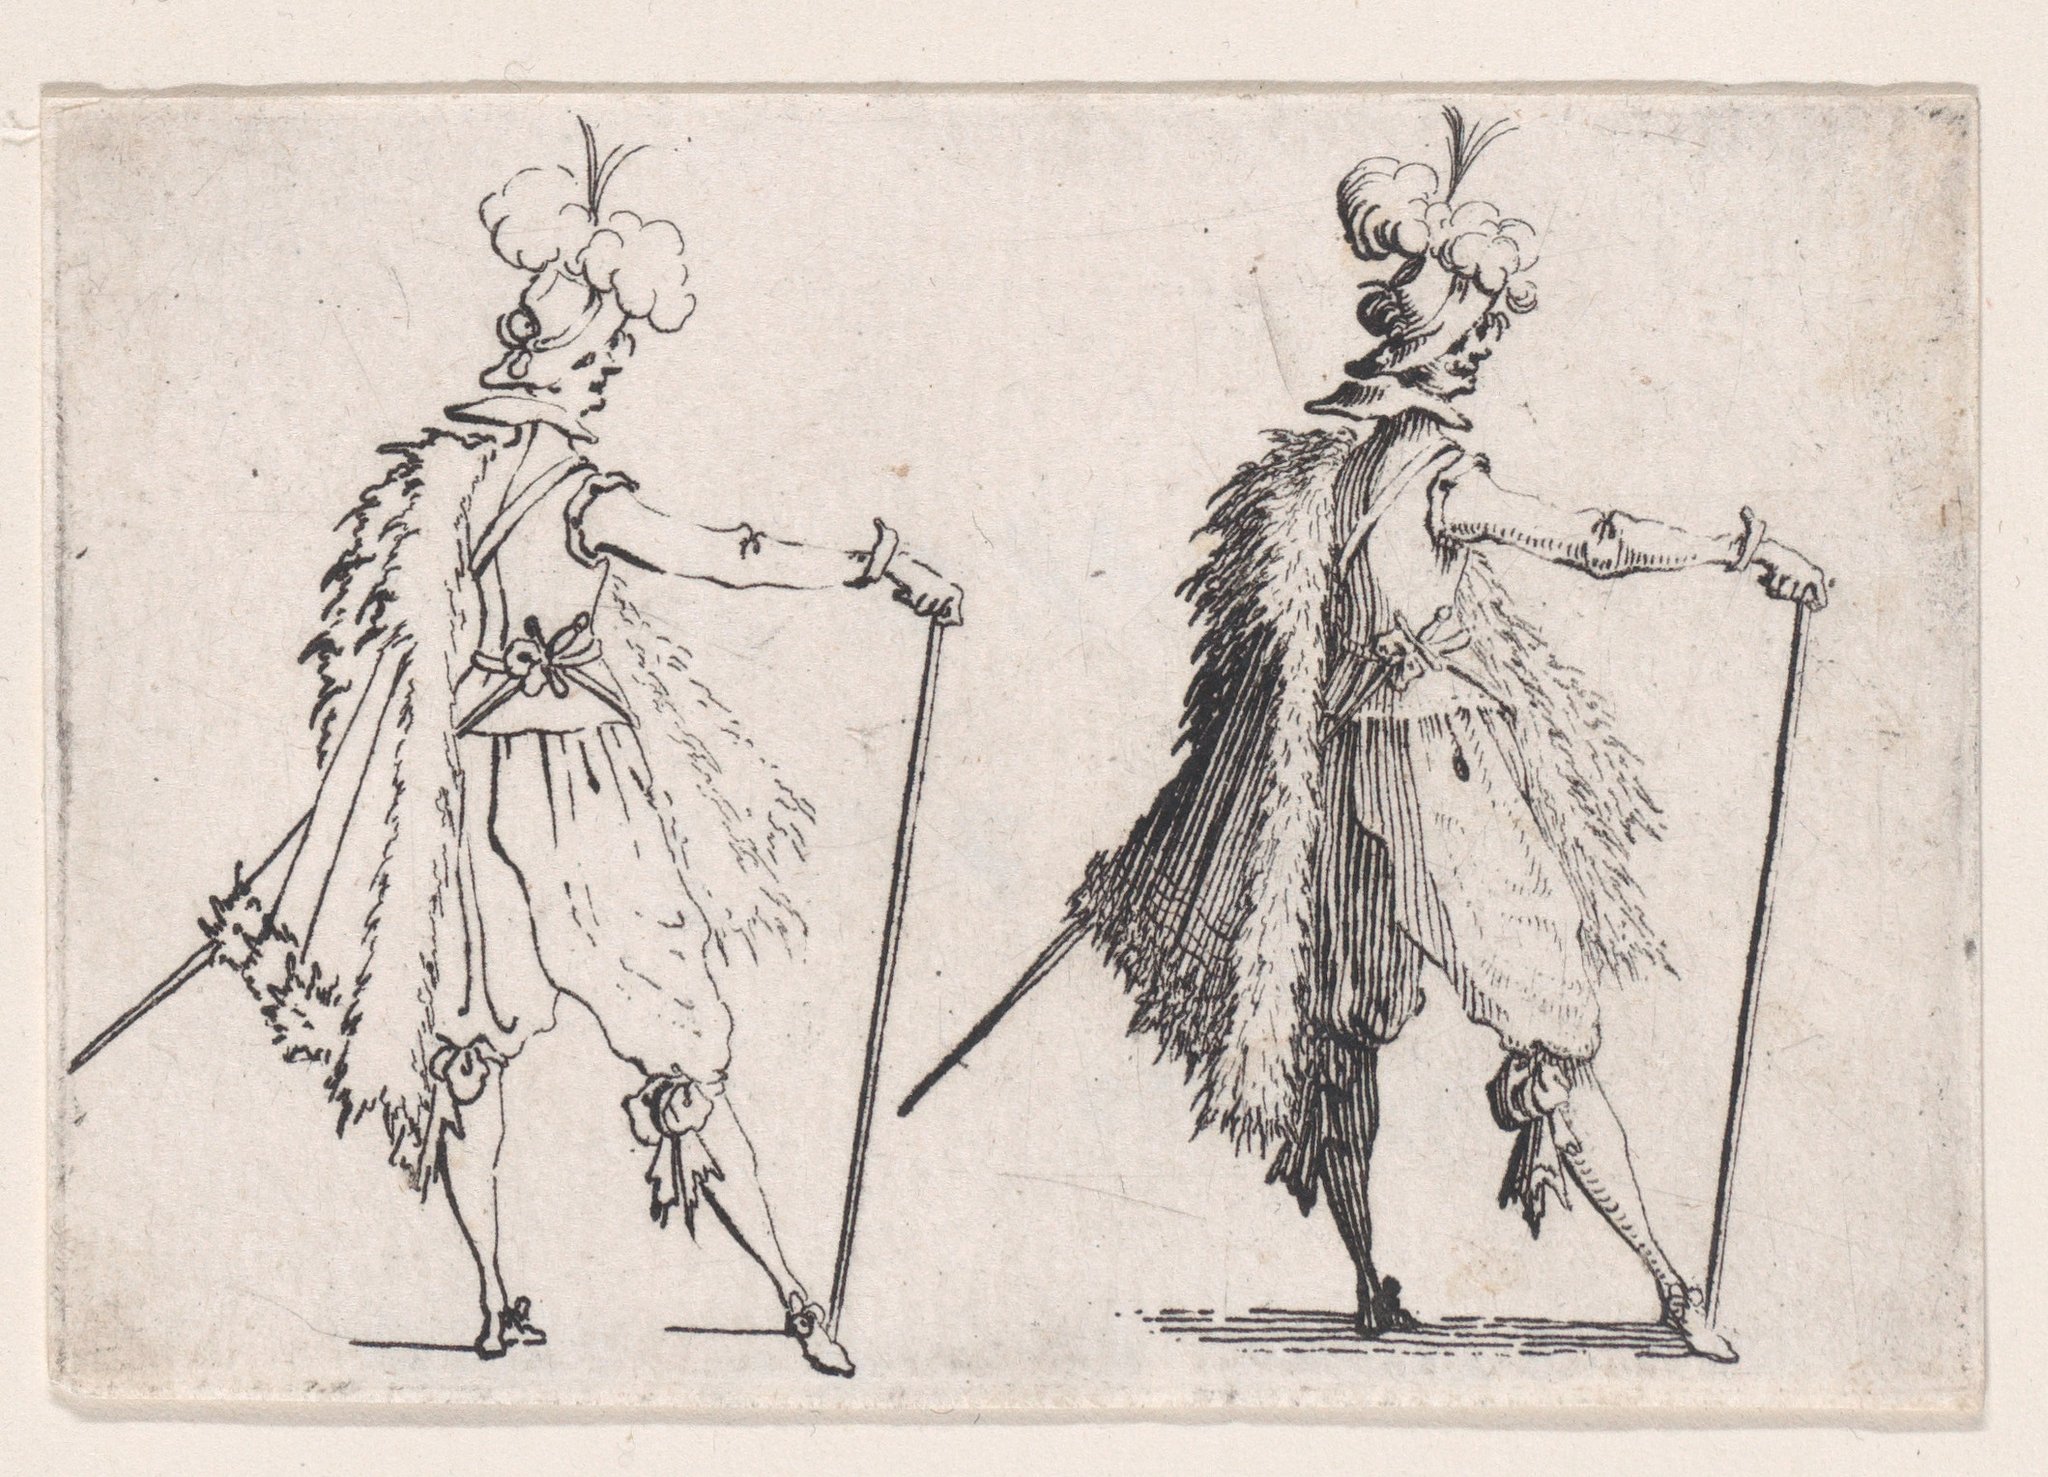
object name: print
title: Le Gentilhomme a la Grande Canne (The Gentleman with the Large Cane), from "Les Caprices" Series A, The Florence Set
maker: jacques callot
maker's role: artist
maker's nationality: french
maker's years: 1592-1635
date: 1617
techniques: etching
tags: men